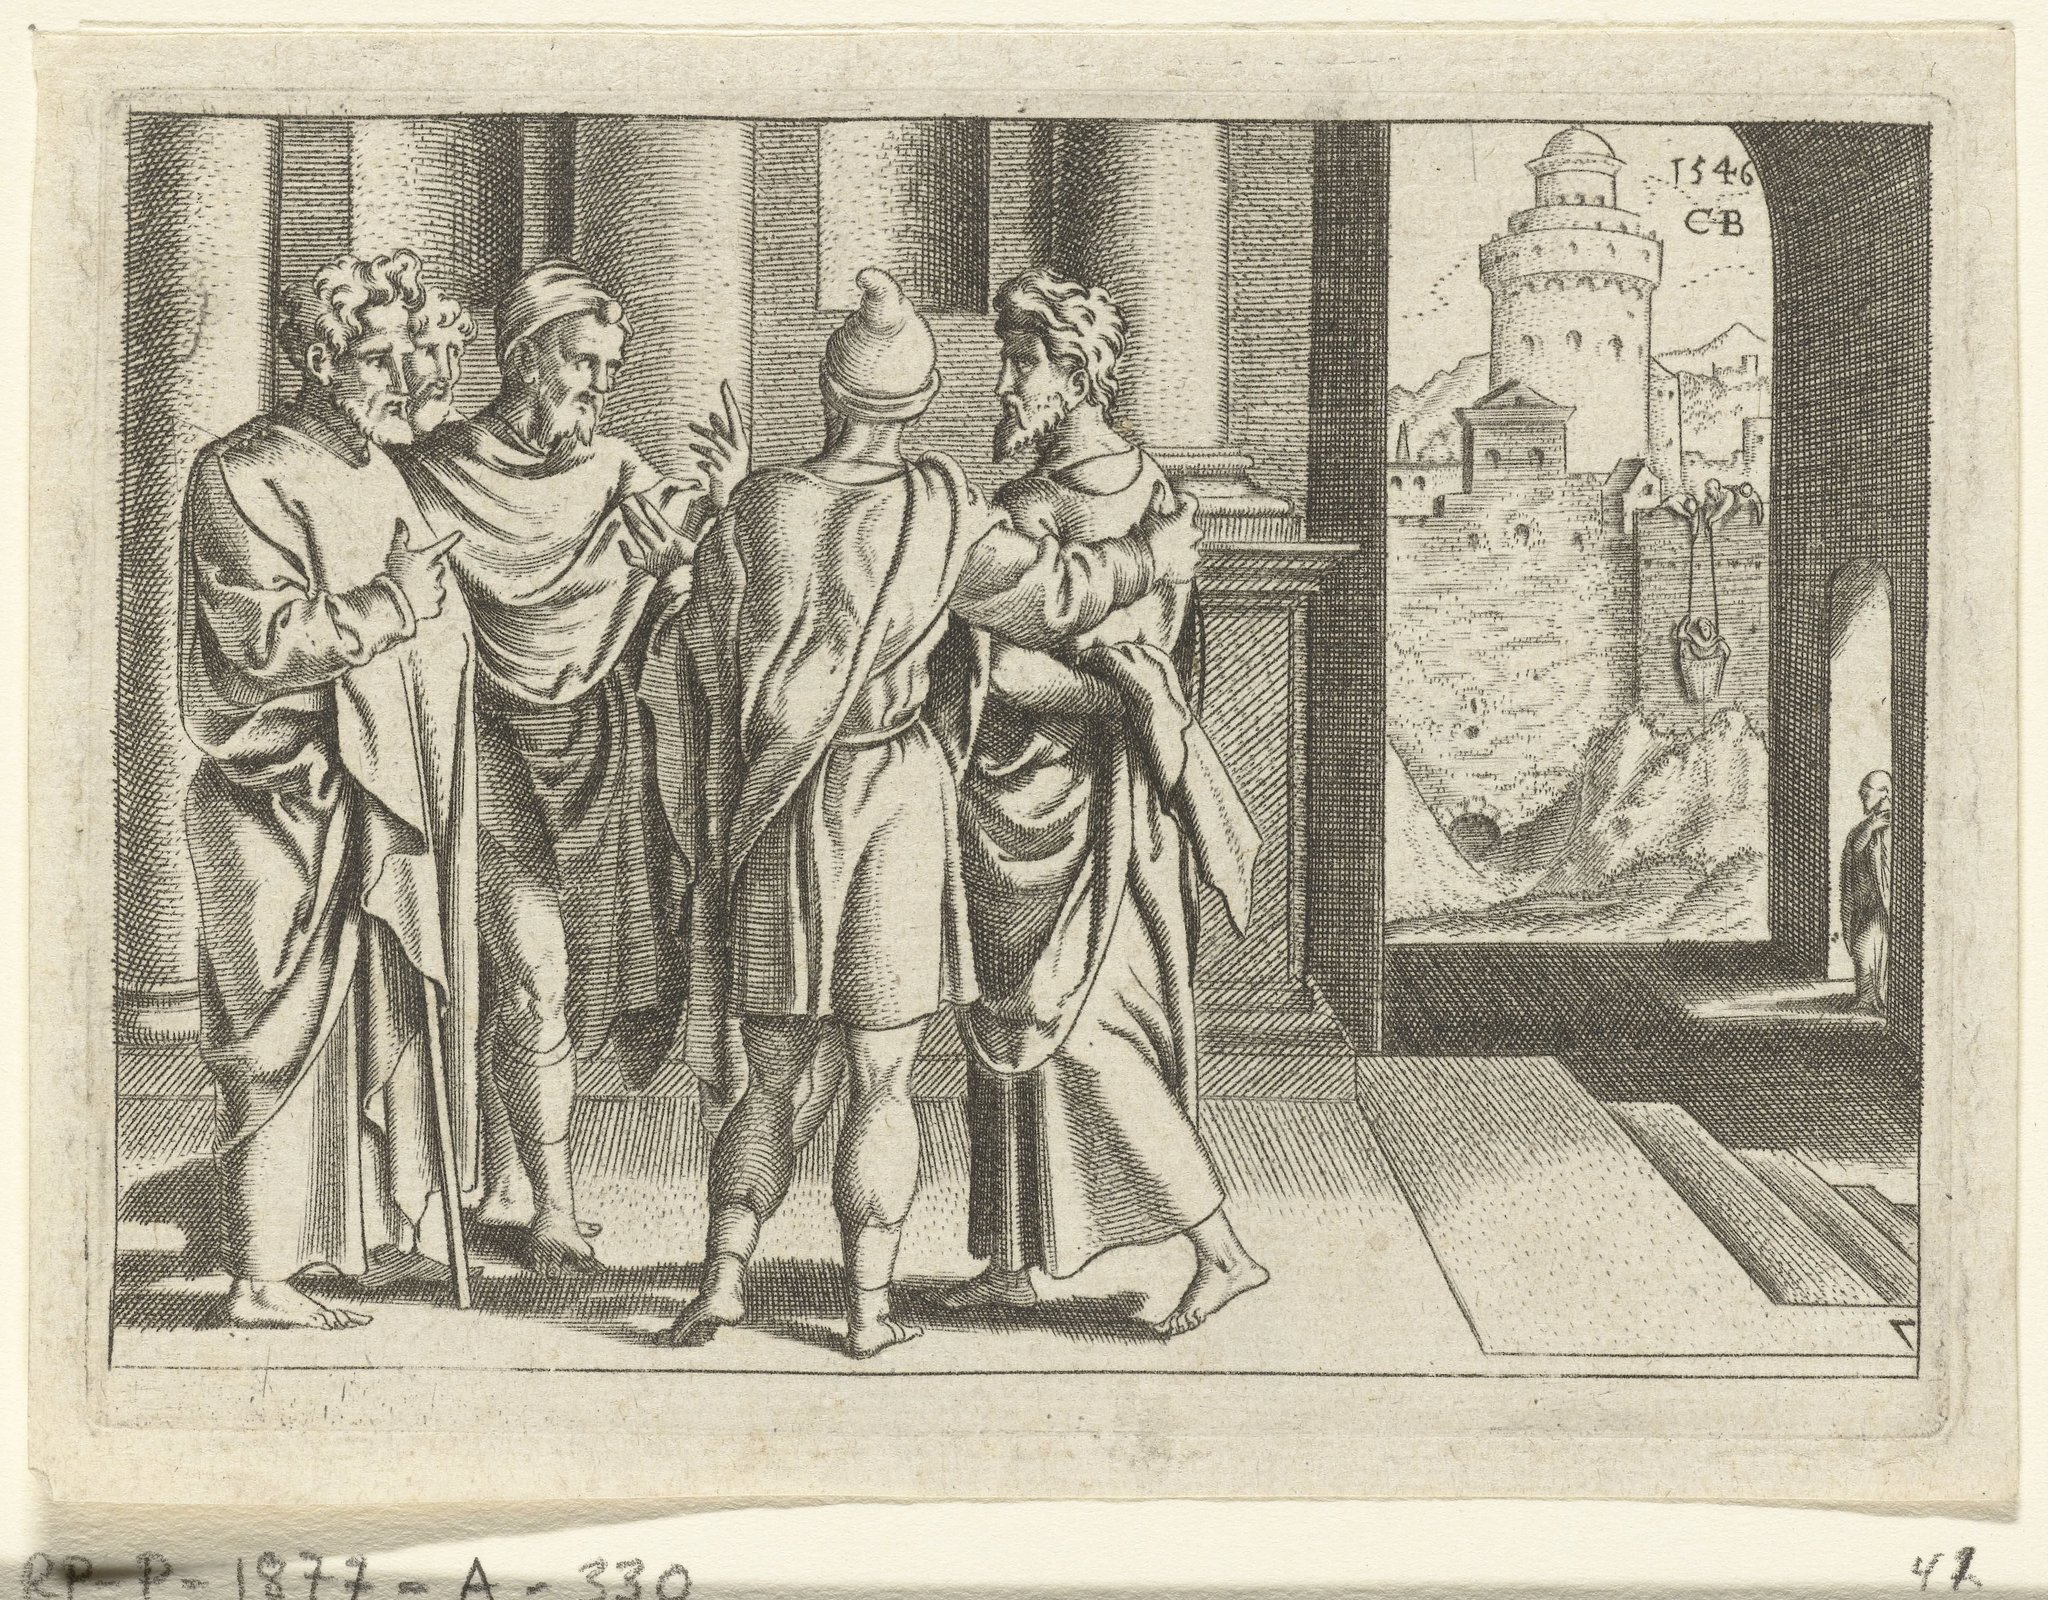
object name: print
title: Het leven van Paulus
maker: cornelis bos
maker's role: print maker, printer, publisher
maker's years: 1510-1566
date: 1546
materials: paper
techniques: engraving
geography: groningen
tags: disciples let paul down the wall of the city in a basket, in jerusalem barnabas brings paul to the apostles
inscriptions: collector's mark: Lugt 2228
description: In Jeruzalem brengt Barnabas Paulus naar de apostelen. Door de open deur is te zien hoe Paulus met behulp van een mand Damascus kan ontvluchten. Prent uit een serie van 10 prenten met scènes uit het leven van de apostel Paulus.